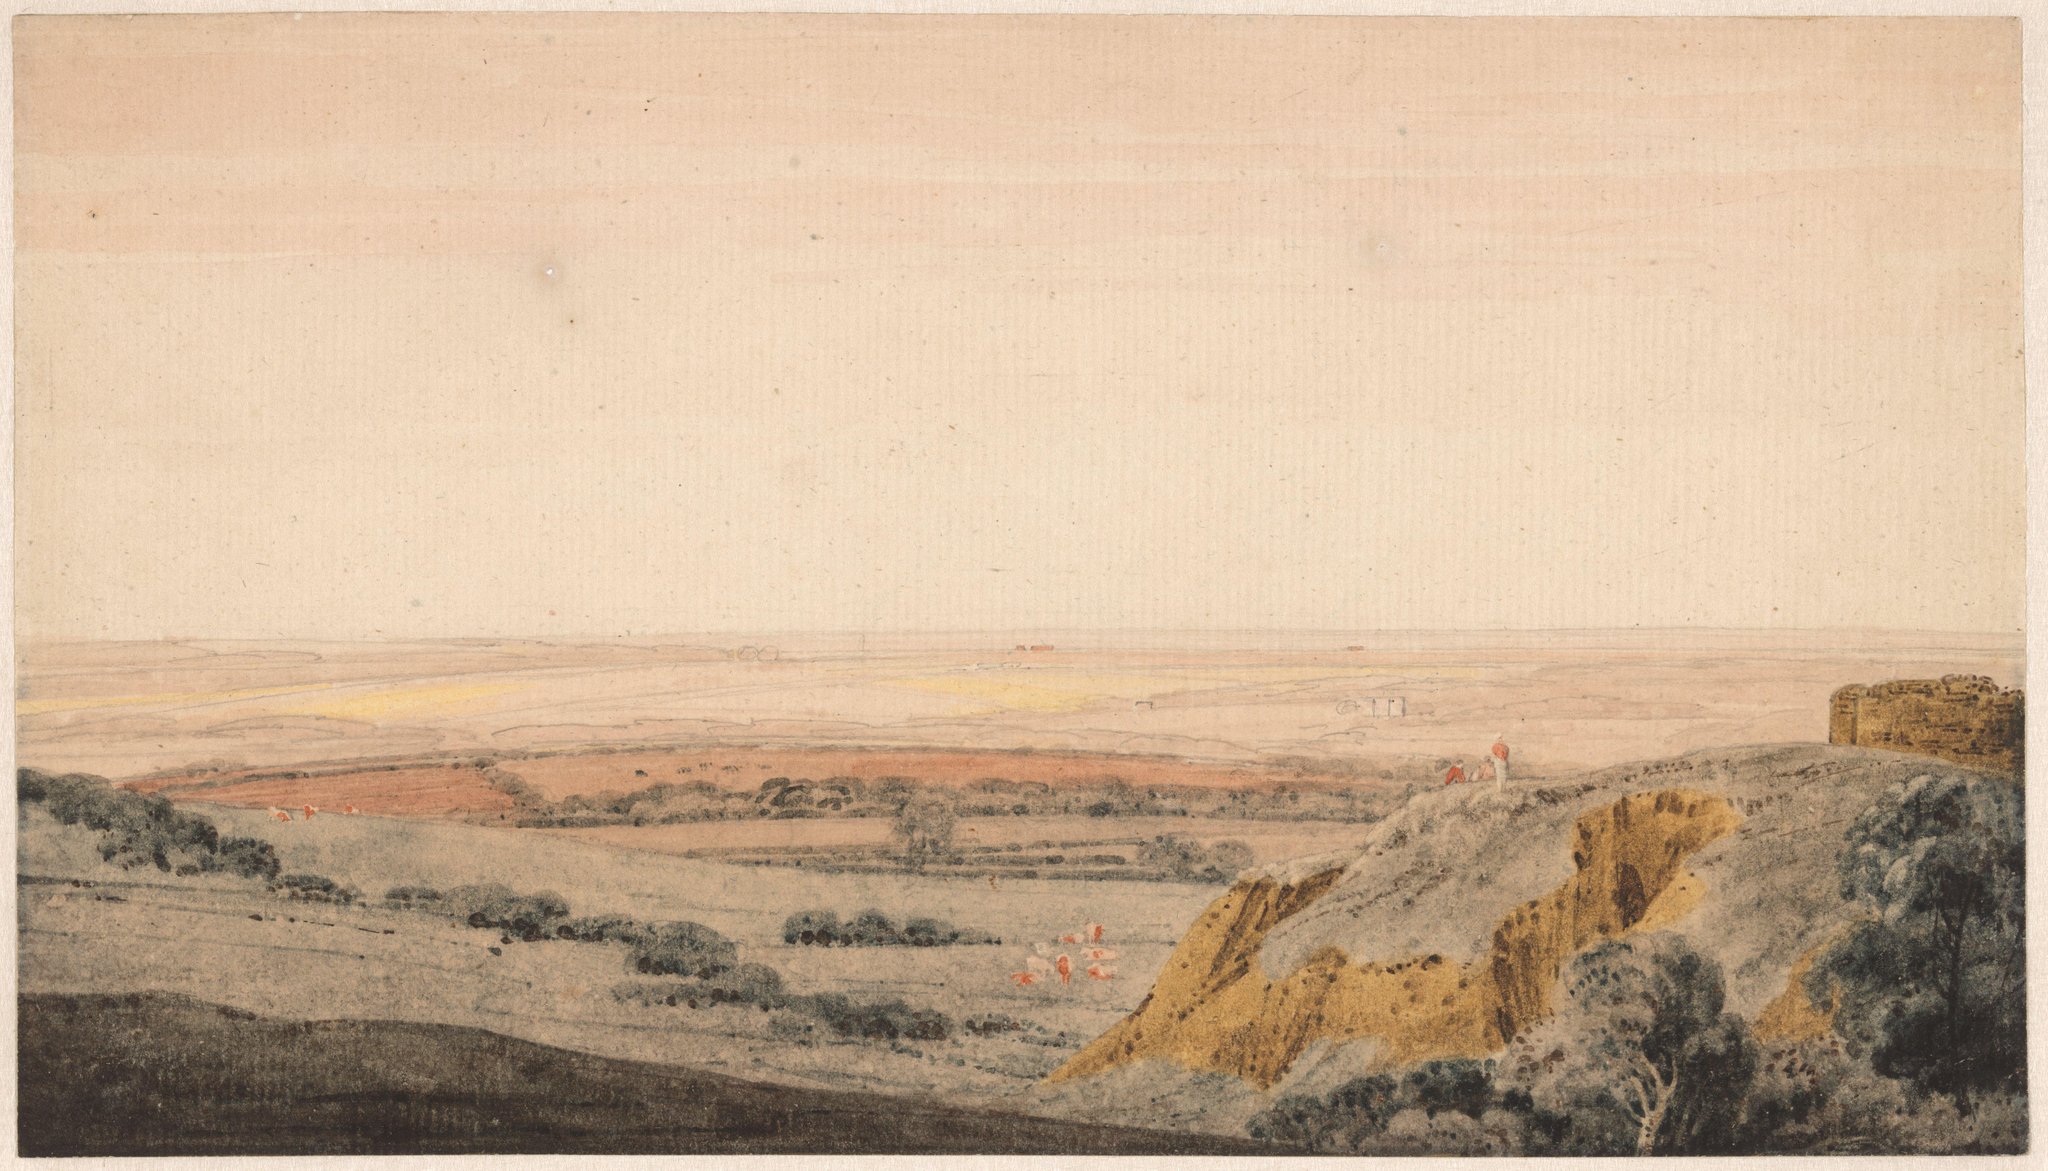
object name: drawing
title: Landschap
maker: william pearson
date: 1878-1943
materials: paper, watercolor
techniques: brush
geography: england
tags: low hill country